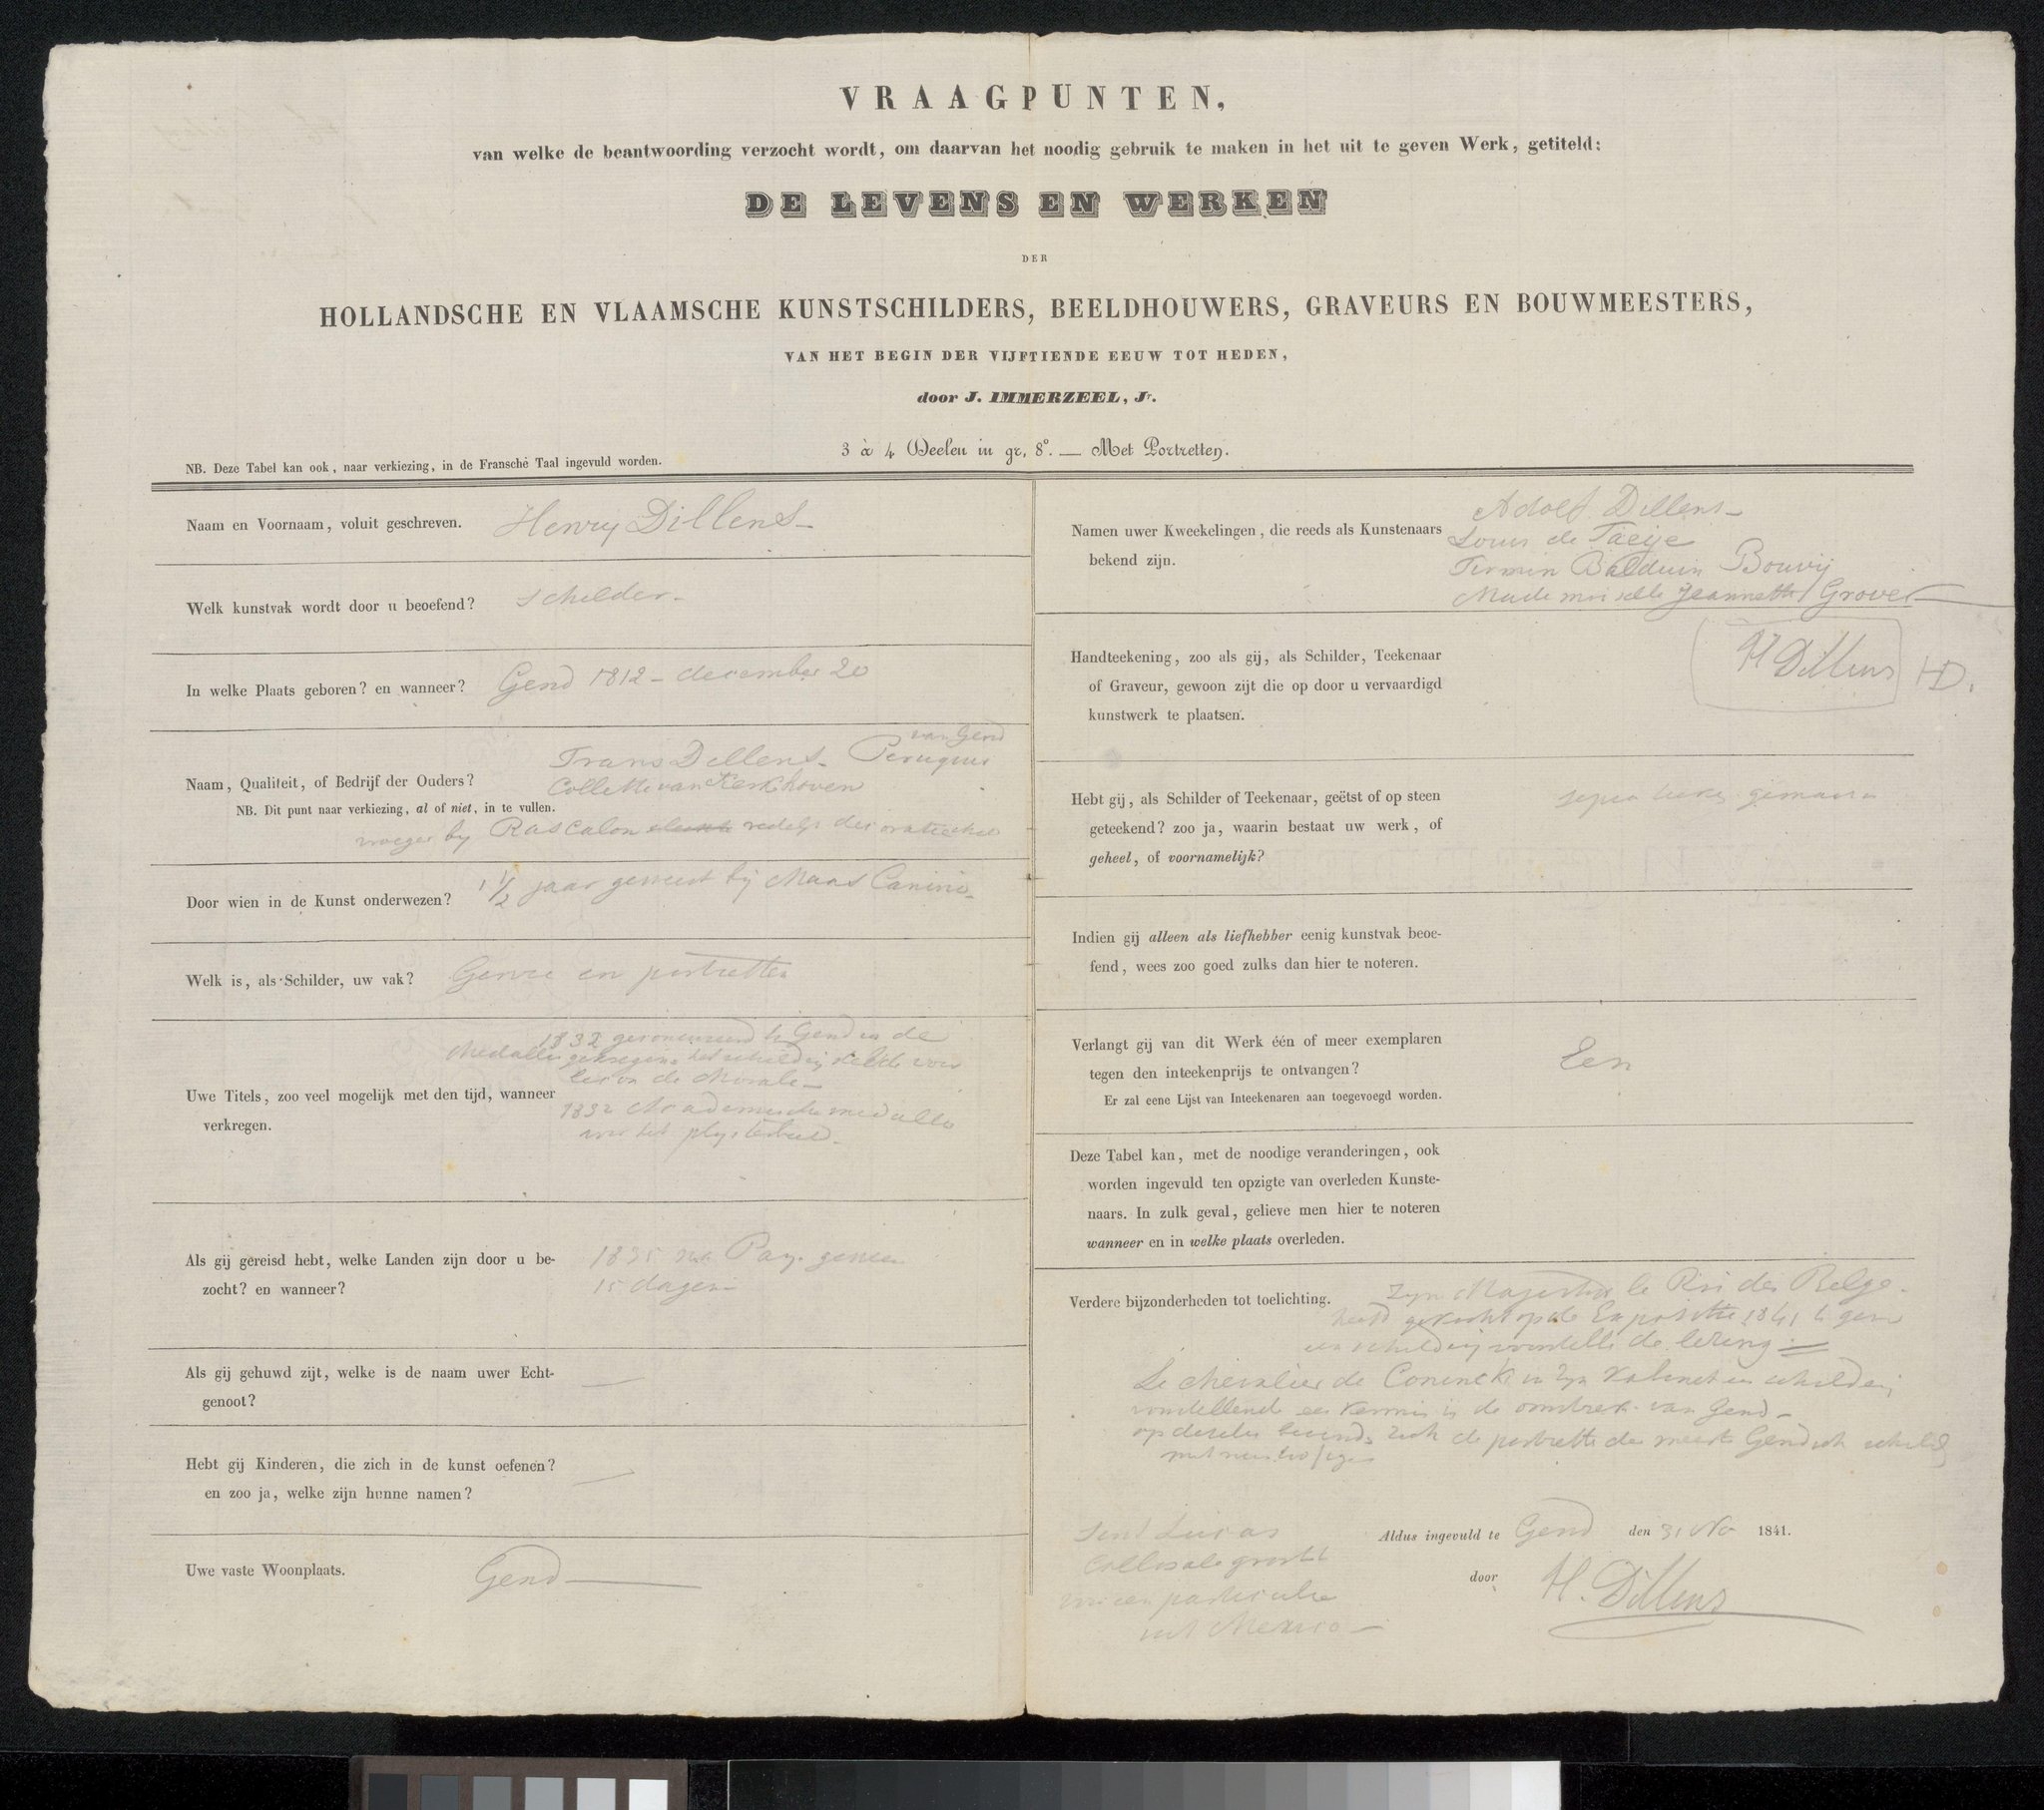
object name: manuscript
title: Enquêteformulier ingevuld door Henri Dillens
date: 1841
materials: paper, pencil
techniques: printing, writing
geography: ghent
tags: ghent, brussels, painter, print maker, draughtsman, henri dillens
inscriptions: watermark, inscription: ‘Vraagpunten,/ van welke de beantwoording verzocht wordt, om daarvan het noodig gebruik te maken in het uit te geven Werk, getiteld: De levens en werken/ der Hollandsche en Vlaamsche kunstschilders, beeldhouwers,/ graveurs en bouwmeesters, van het begin der vijftiende eeuw tot heden/ door J. Immerzeel, Jr.’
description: Opgenomen in: Immerzeel, J. Jr., De levens en werken der Hollandsche en Vlaamsche kunstschilders, beeldhouwers, graveurs en bouwmeesters, van het begin der vijftiende eeuw tot heden, Amsterdam: J.C. van Kesteren, 1842-1843.